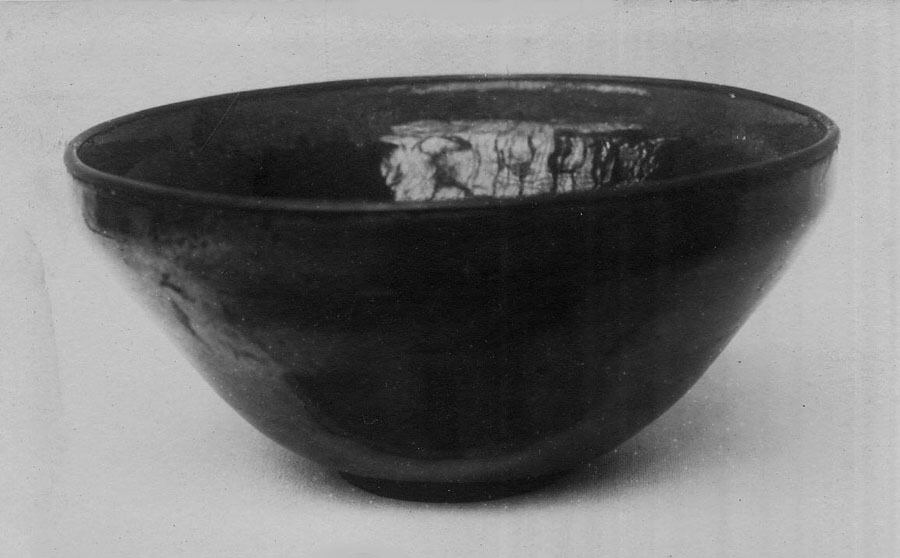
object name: teabowl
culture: japanese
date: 1801-1900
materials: glaze, metal, pottery